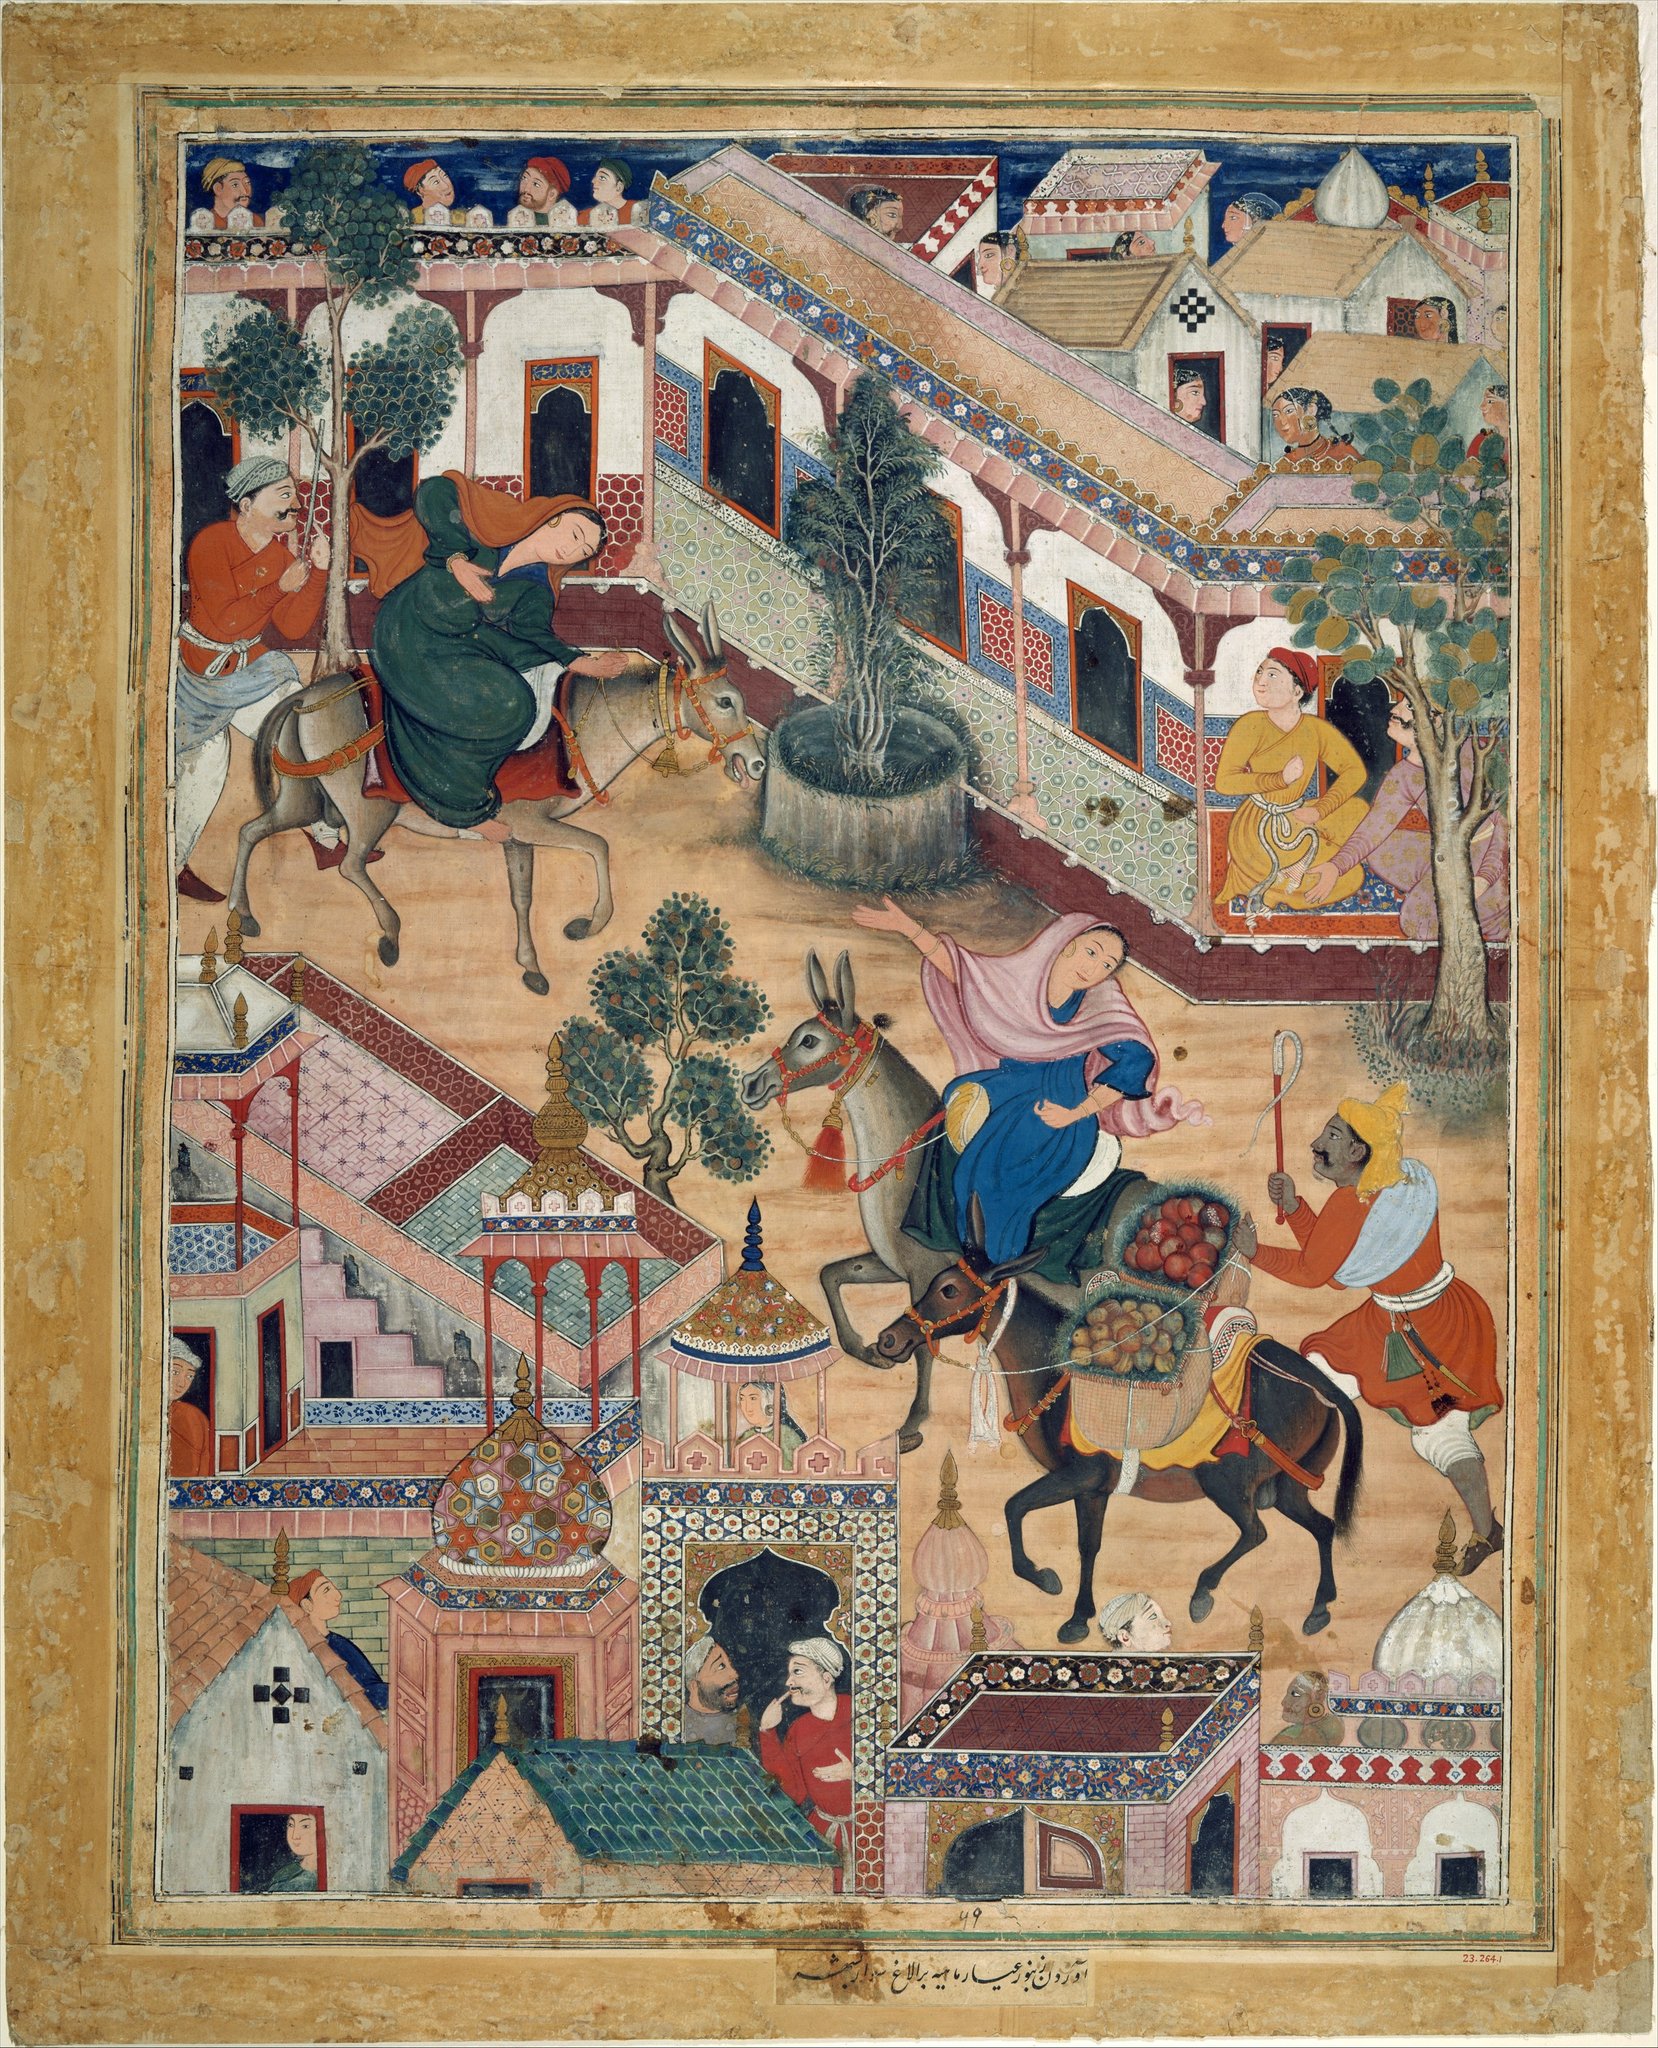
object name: folio from an illustrated manuscript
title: "The Spy Zambur Brings Mahiya to the City of Tawariq", Folio from a Hamzanama (Book of Hamza)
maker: kesav das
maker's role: artist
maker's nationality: indian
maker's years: 1545-1630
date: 1570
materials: textile, gold, ink, paper, watercolor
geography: india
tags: towns,men,women,donkeys